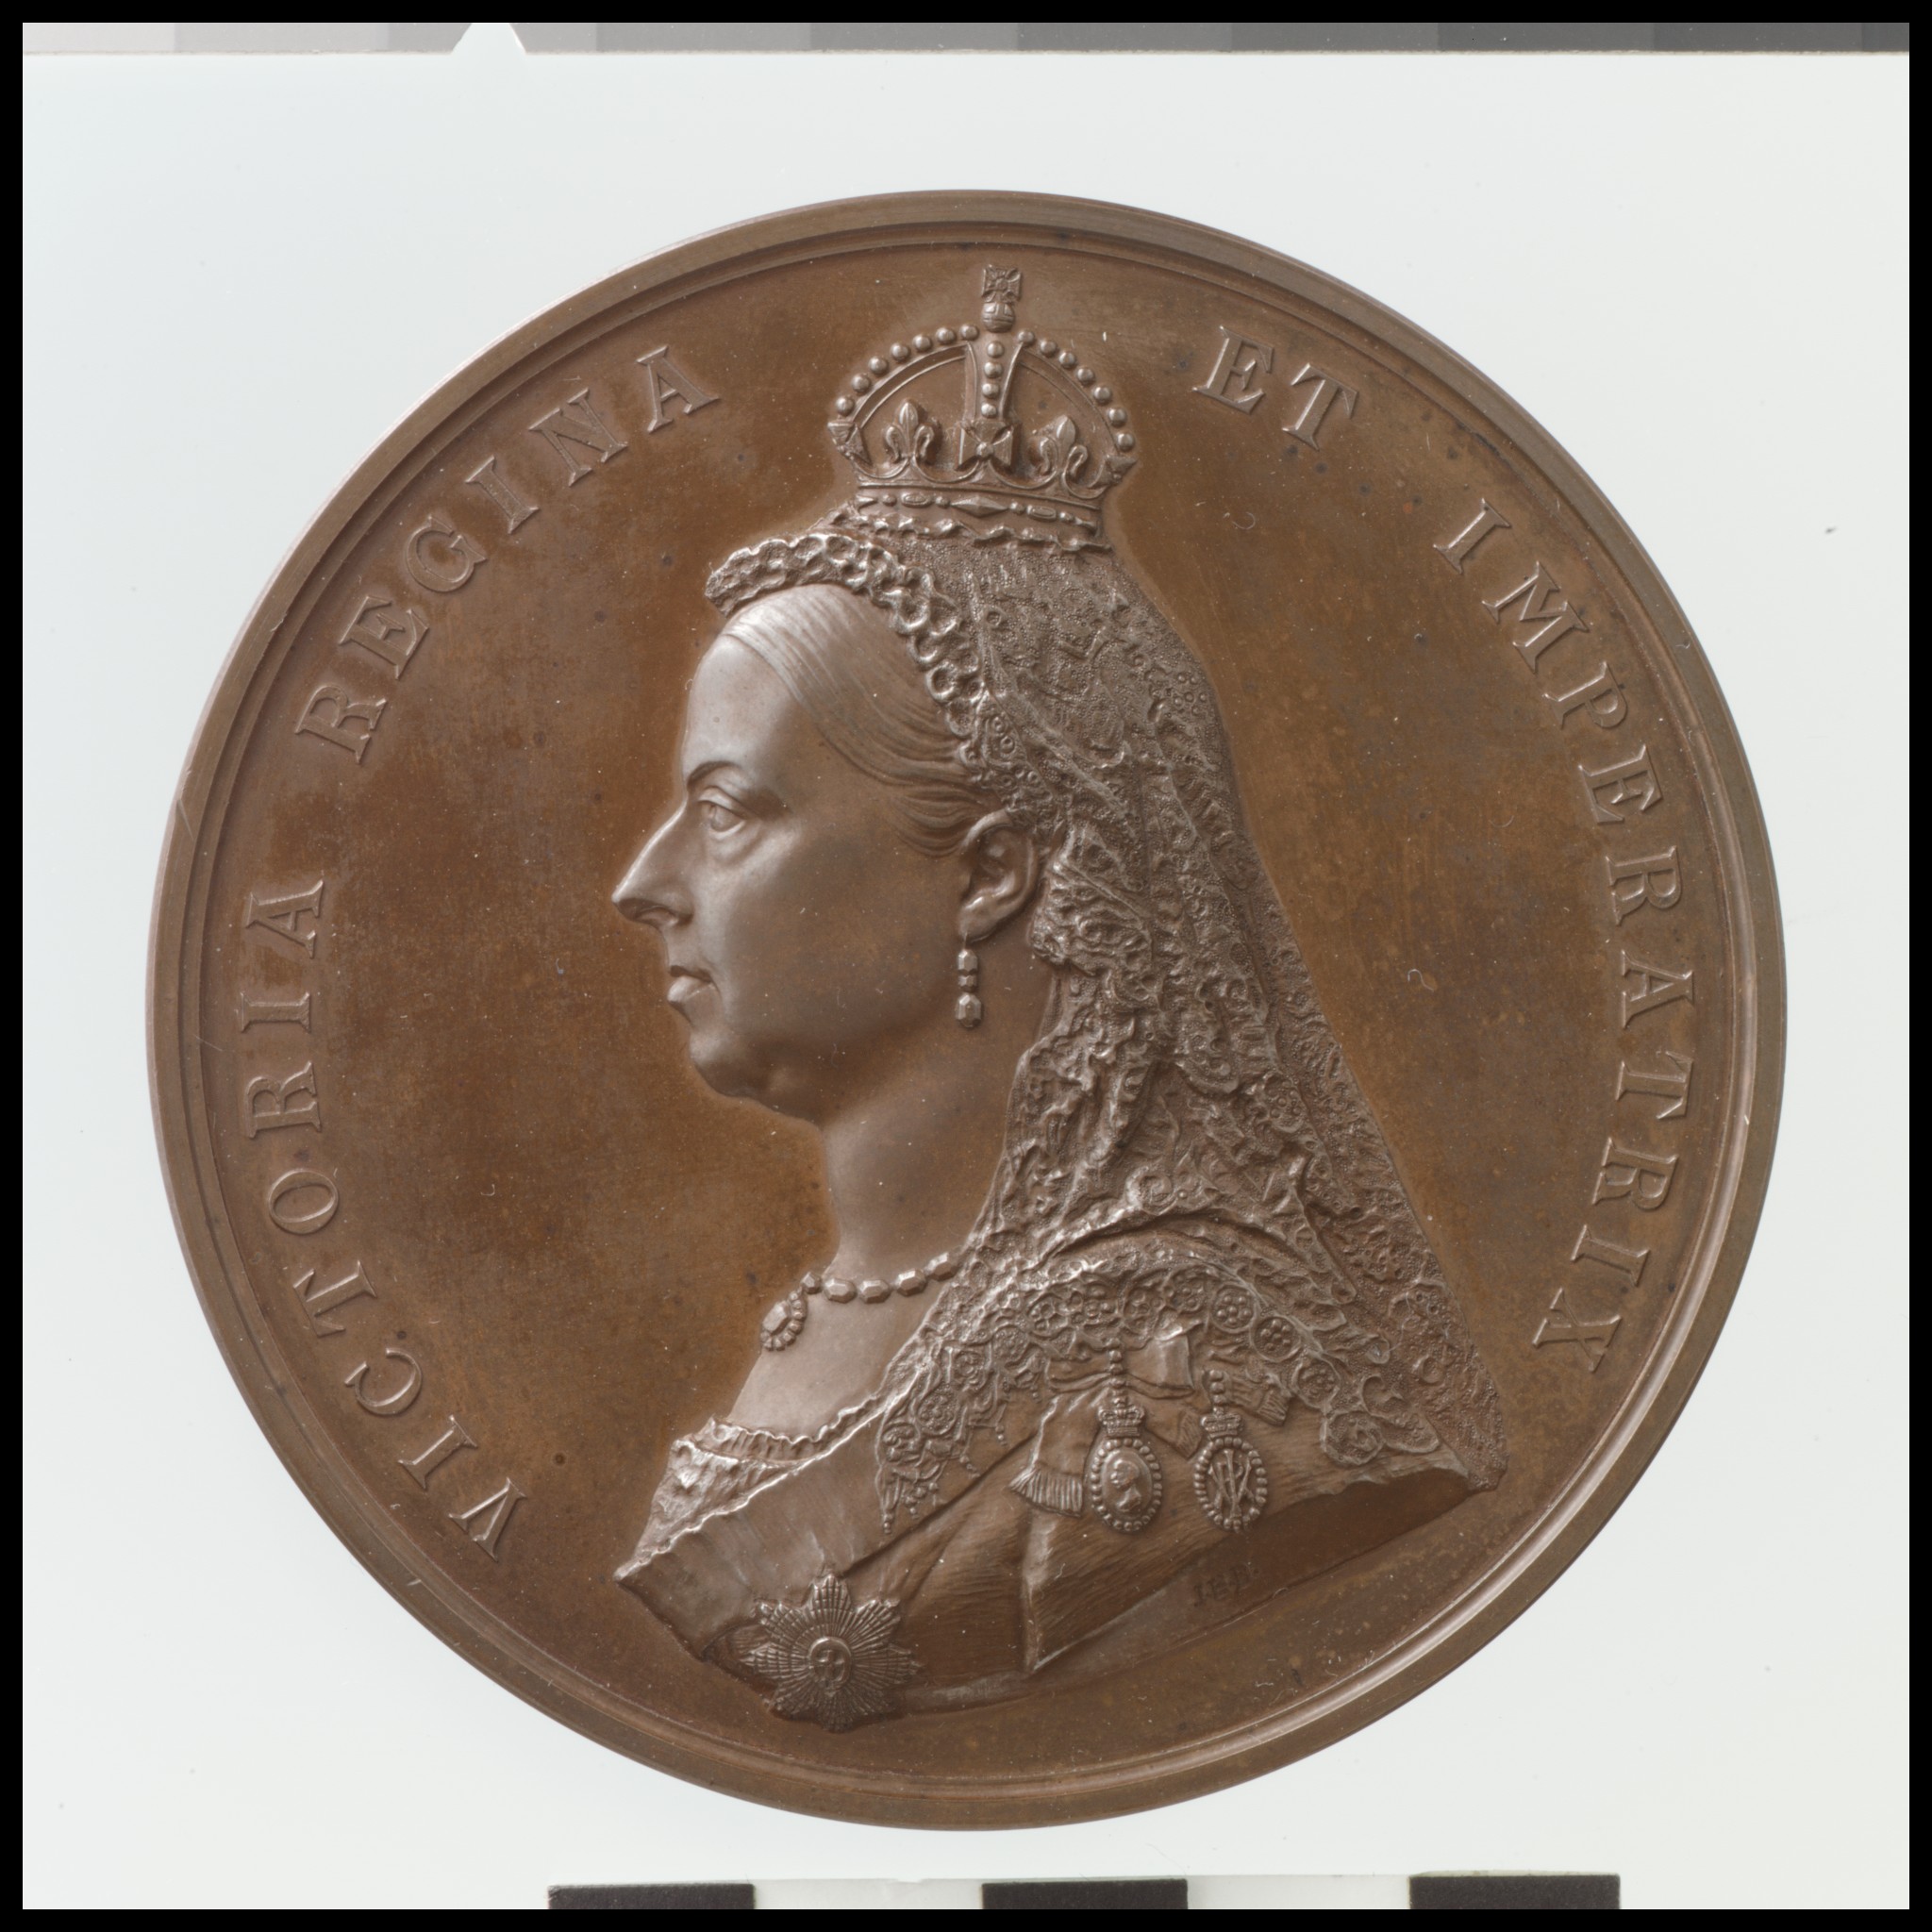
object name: medal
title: Golden Jubilee Medal of Queen Victoria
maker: joseph edgar boehm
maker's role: maker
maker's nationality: british, born austria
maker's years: 1834-1890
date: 1887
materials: bronze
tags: profiles,women,queen victoria